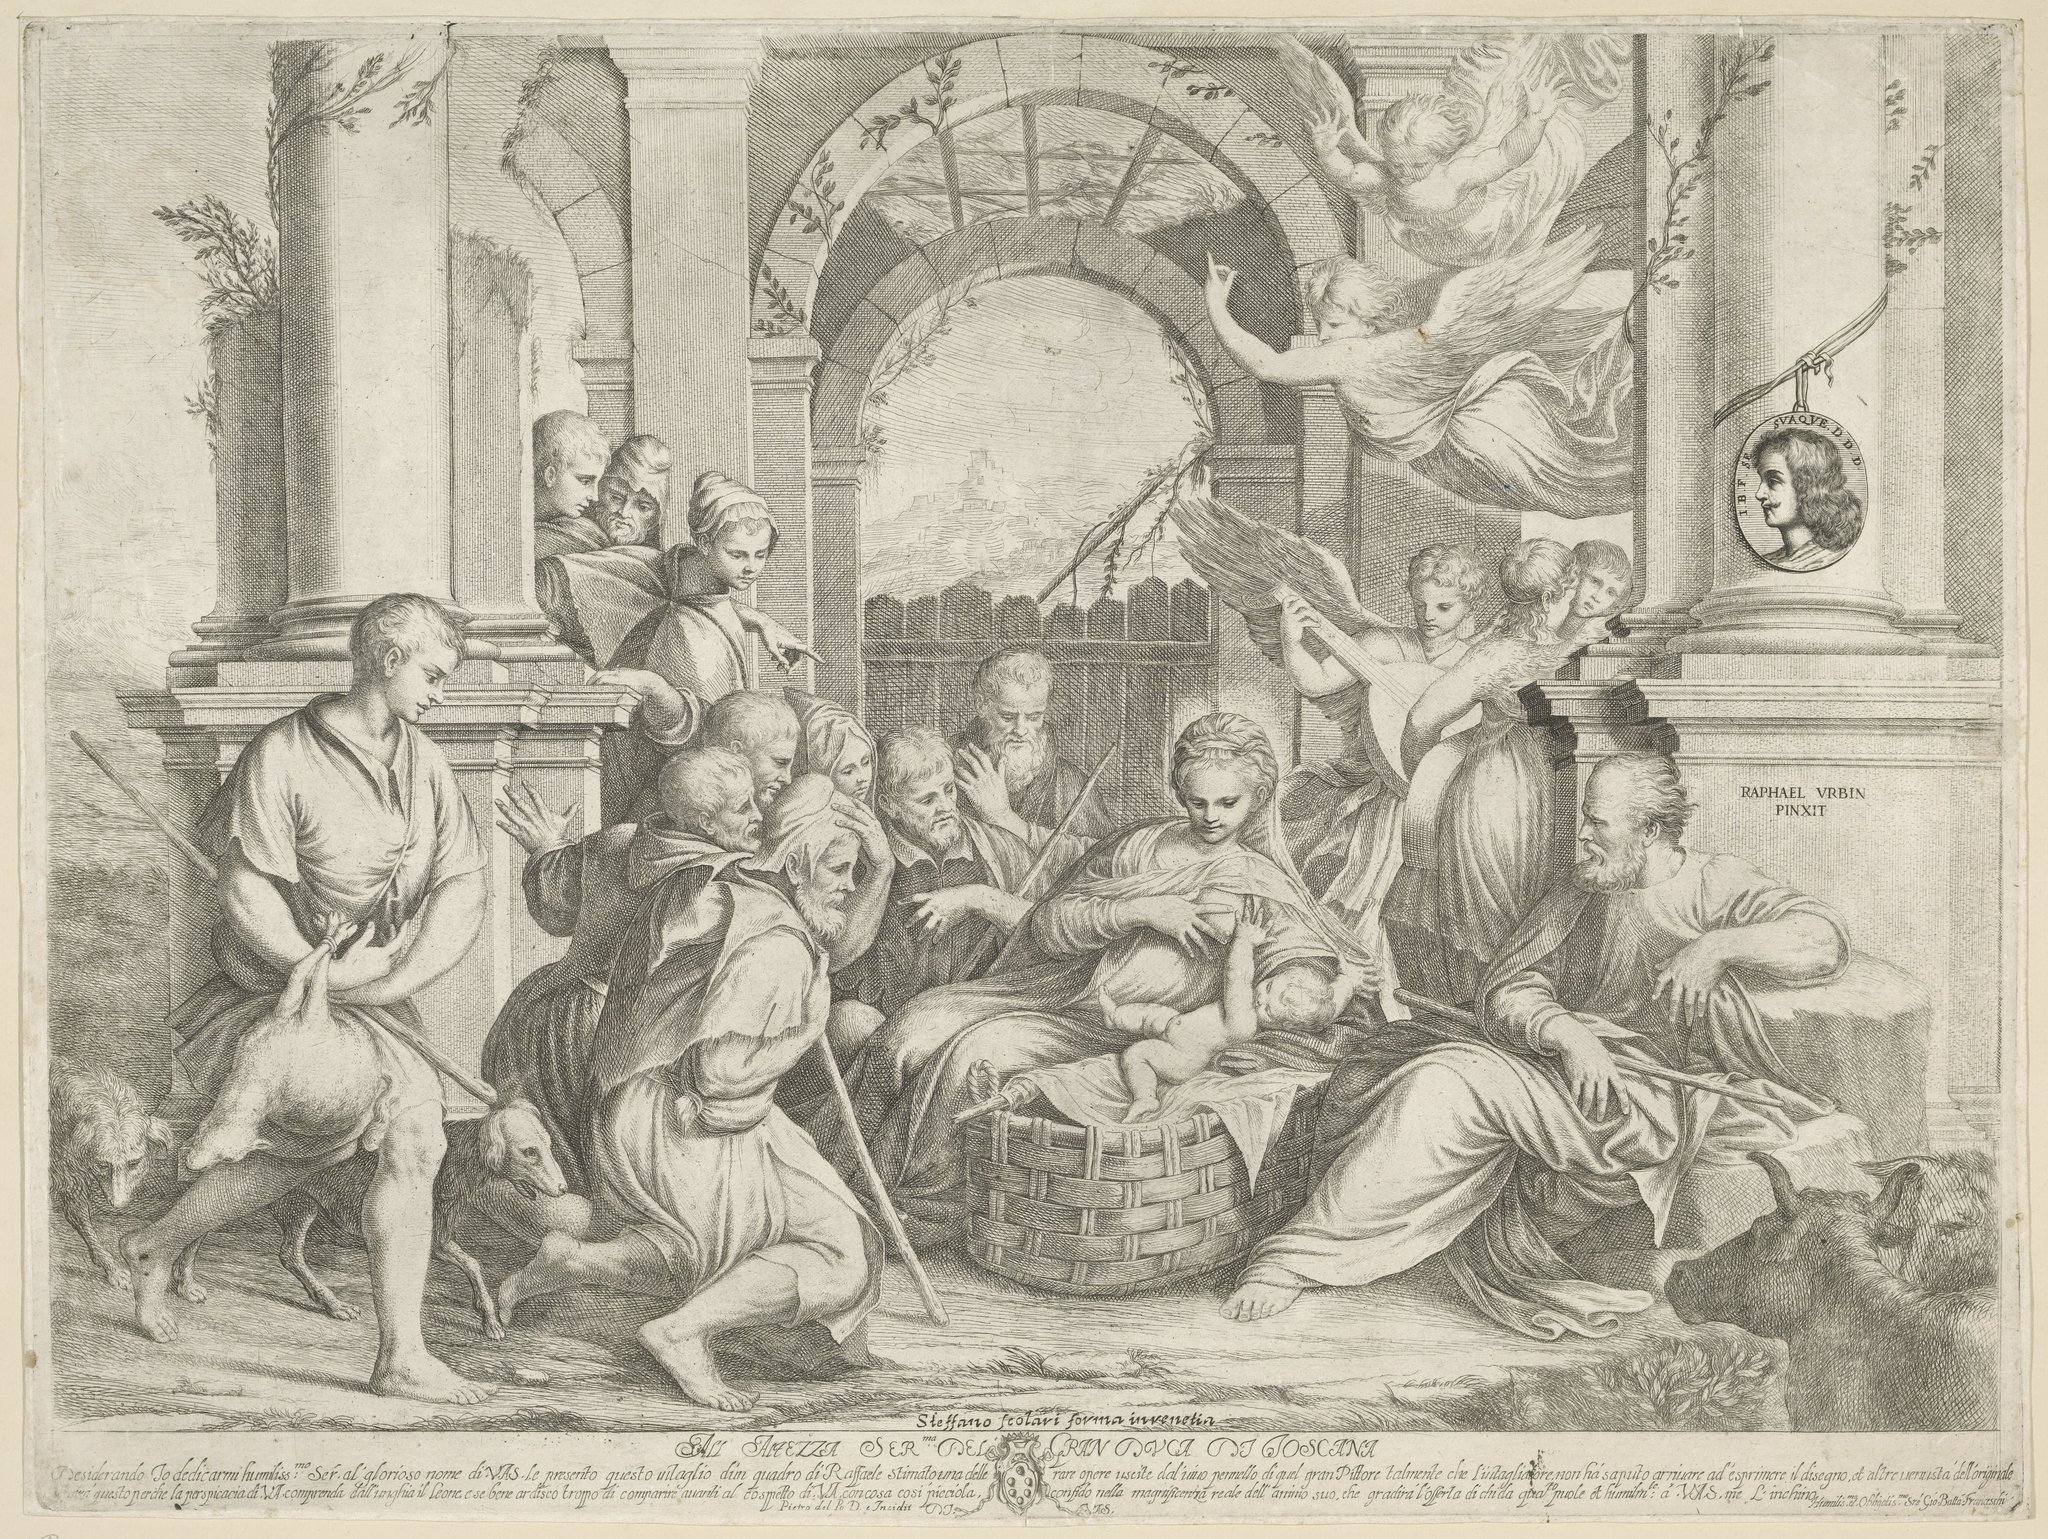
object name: print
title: Aanbidding door de herders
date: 1620-1692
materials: paper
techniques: etching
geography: italy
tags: giovanni battista franceschini, adoration of the christ-child by the shepherds; mary and joseph present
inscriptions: collector's mark: Lugt 240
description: De Heilige Familie zit voor een ruïne van een bouwwerk en wordt omringd door herders en engelen die het Christuskind aanbidden.